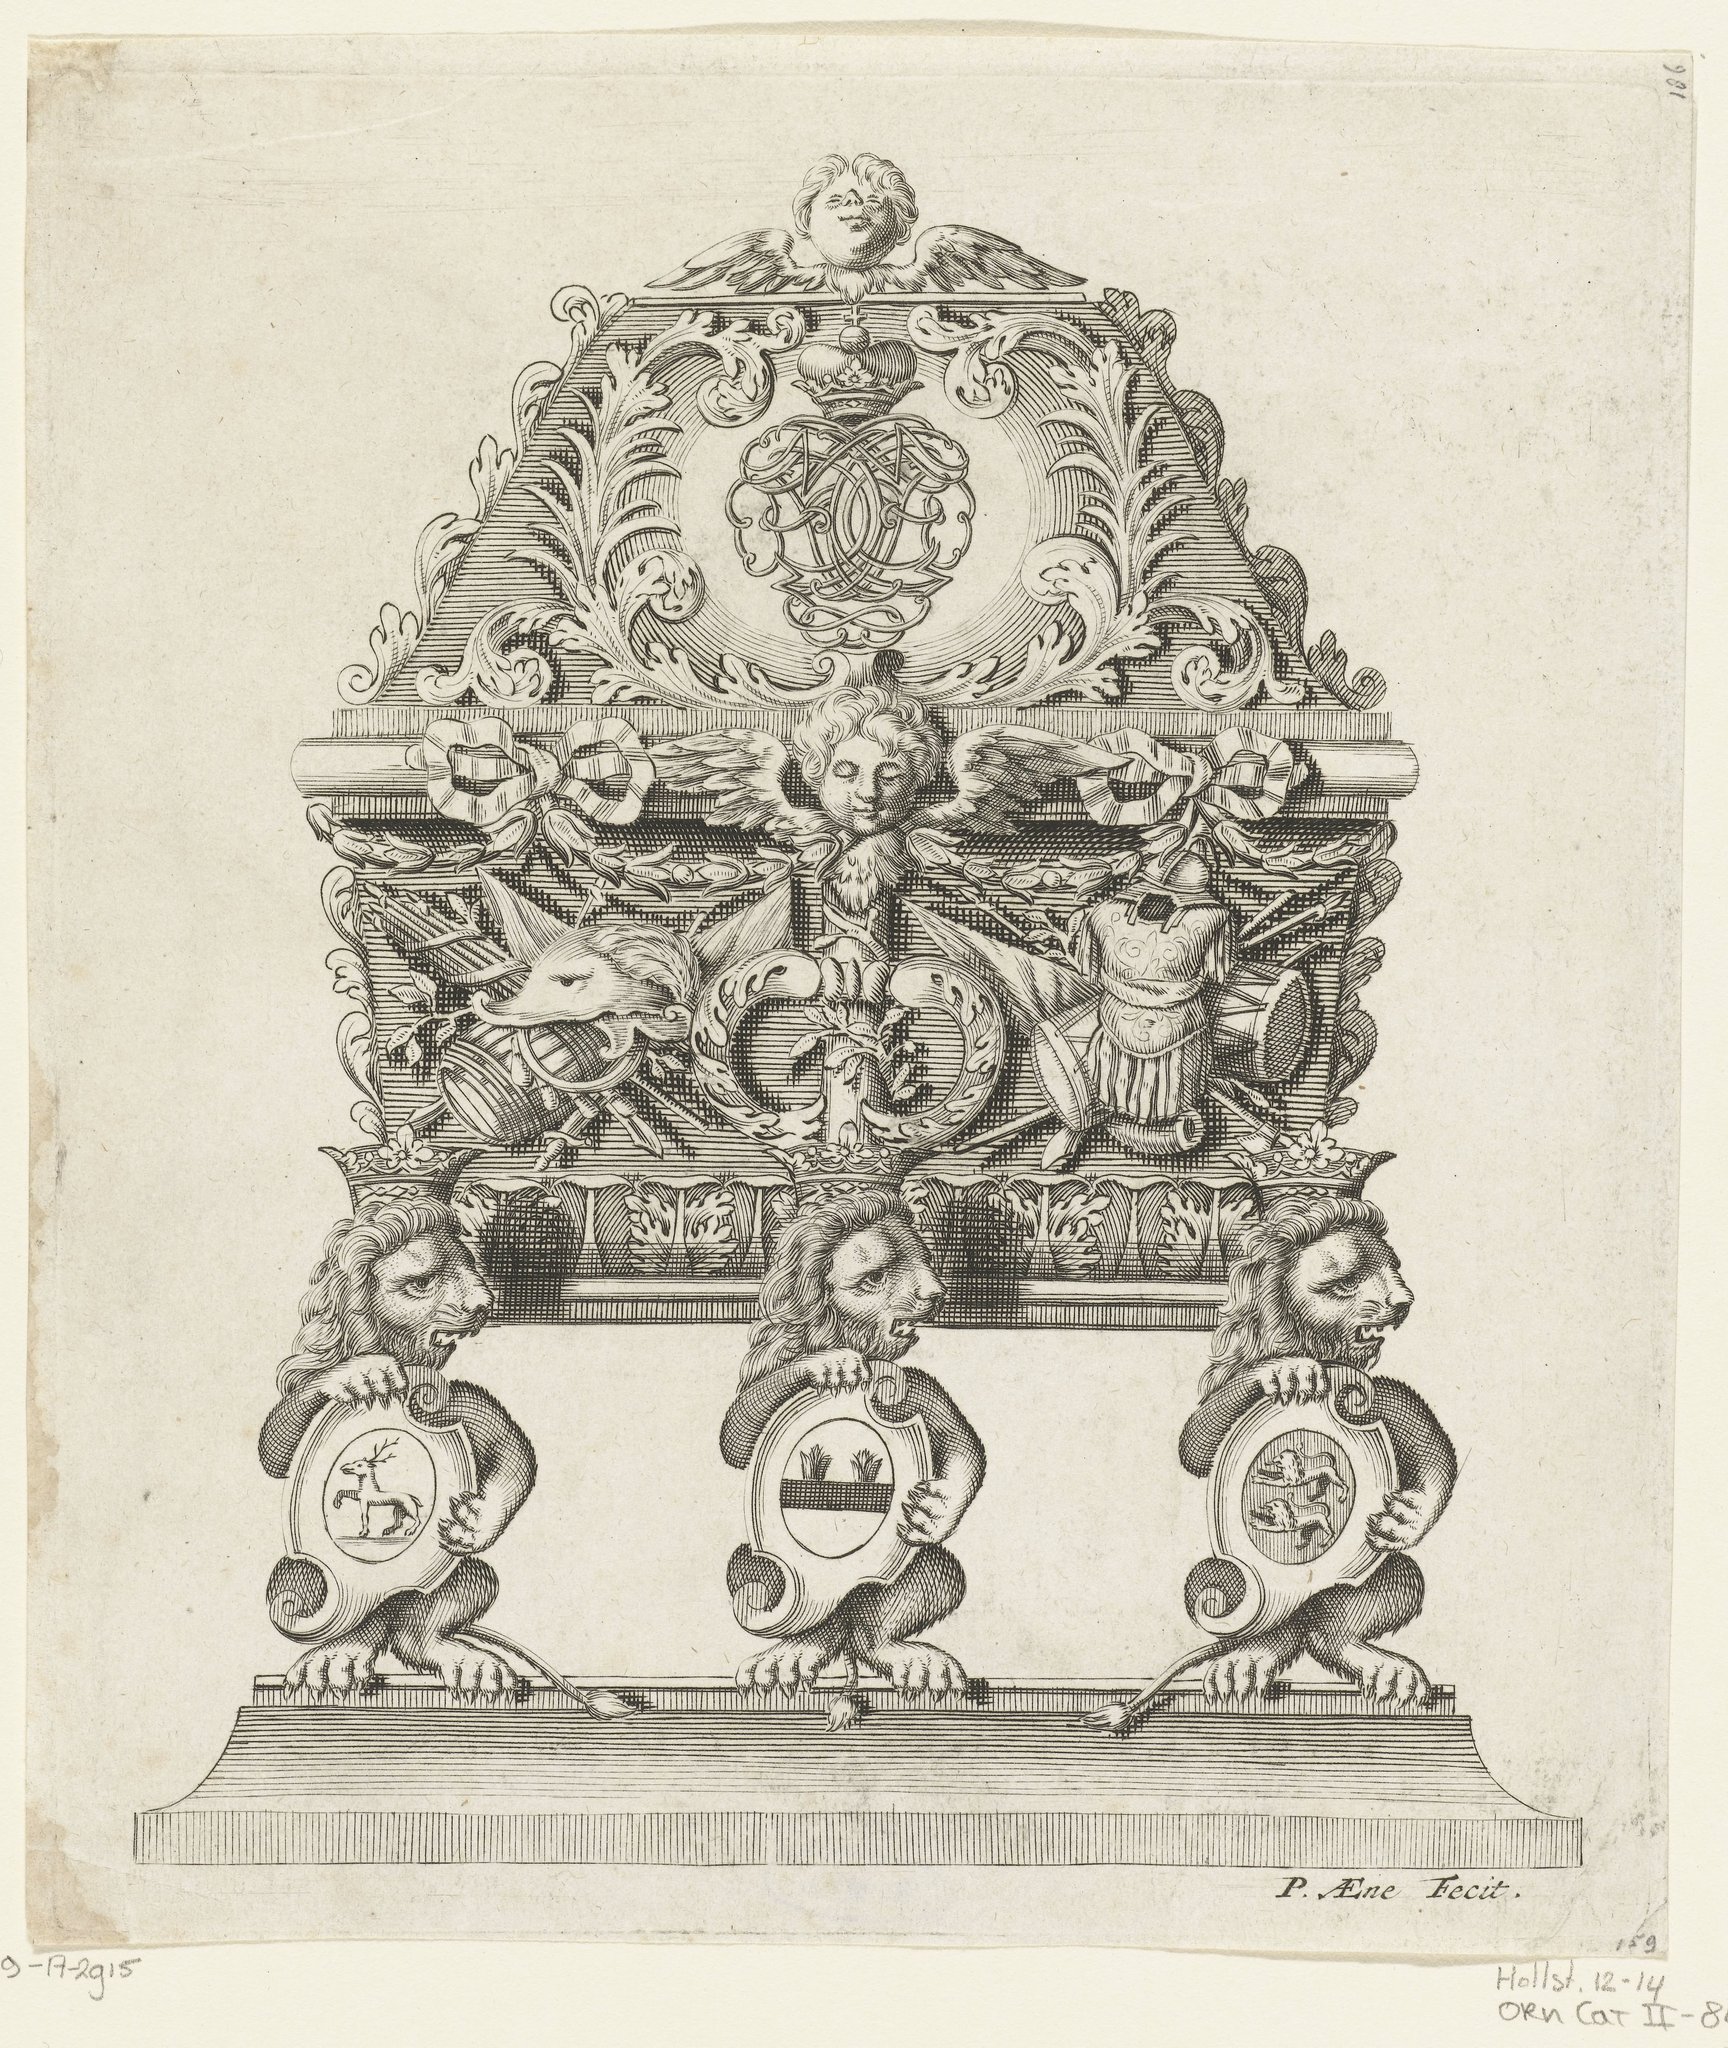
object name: print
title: Sarcofaag van Hendrik Casimir II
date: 1680-1700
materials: paper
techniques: engraving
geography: franeker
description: De sarcofaag steunt op drie leeuwtjes met de wapenschilden van: Spiegelberg (links), Liesveld (midden) en Dietz (rechts). Op het deksel staat het monogram van Hendrik Casimir. Blad uit serie van 3.